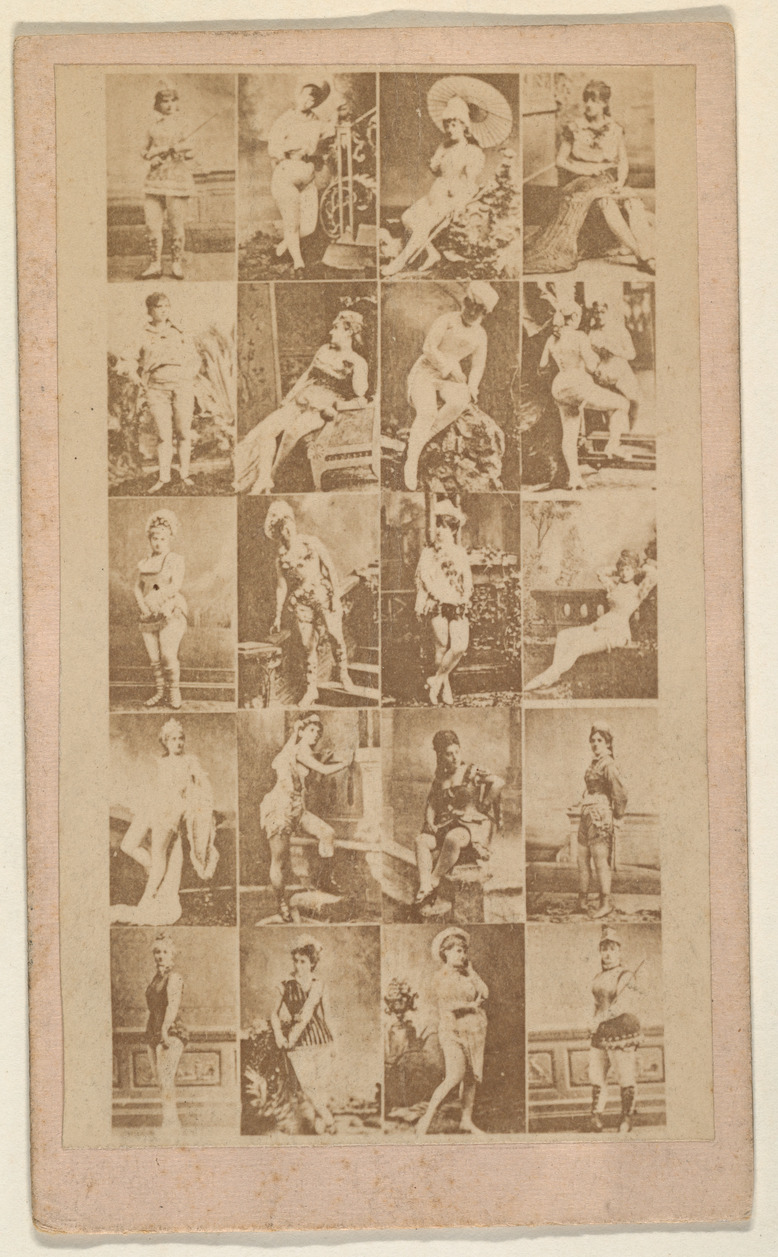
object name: photograph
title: Grid of twenty portraits of actresses (pink), from the Actresses series (N668)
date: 1888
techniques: albumen silver print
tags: portraits,women,actresses